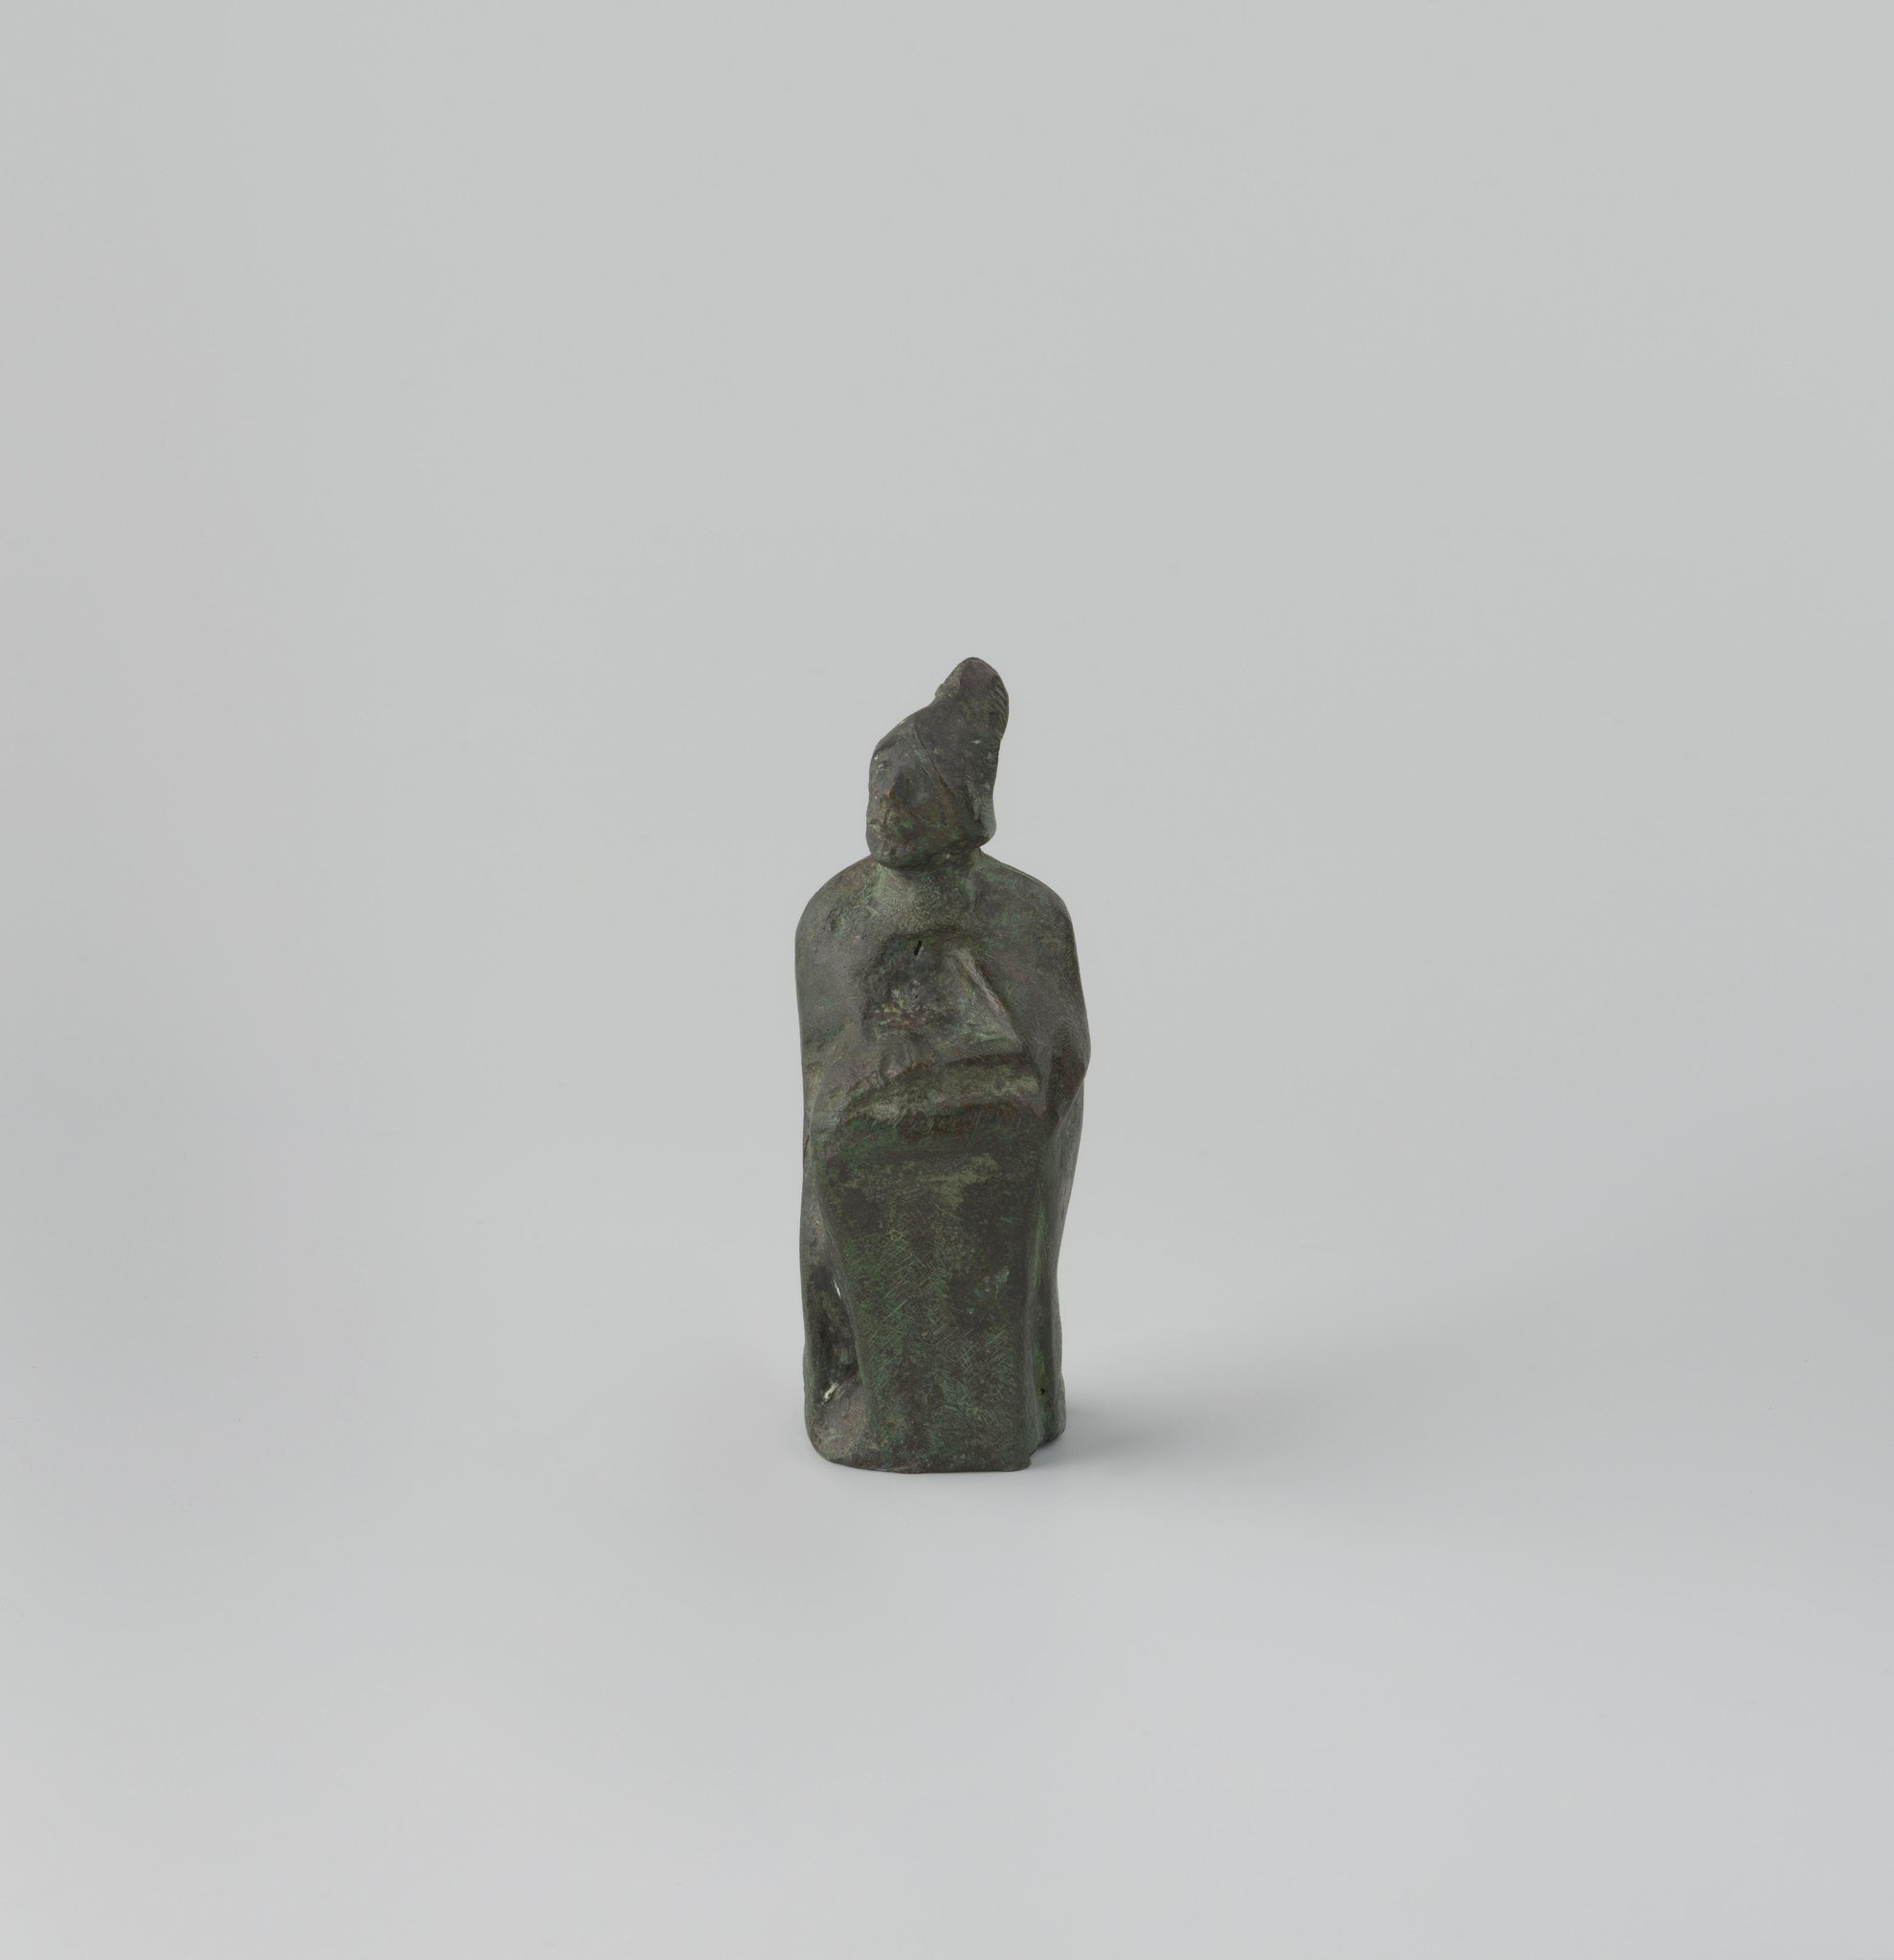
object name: chess piece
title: Pion 7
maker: saar de swart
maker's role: sculptor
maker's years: 1861-1951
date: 1923-1925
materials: bronze, oxide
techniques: casting, lost wax process, patinaed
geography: capri